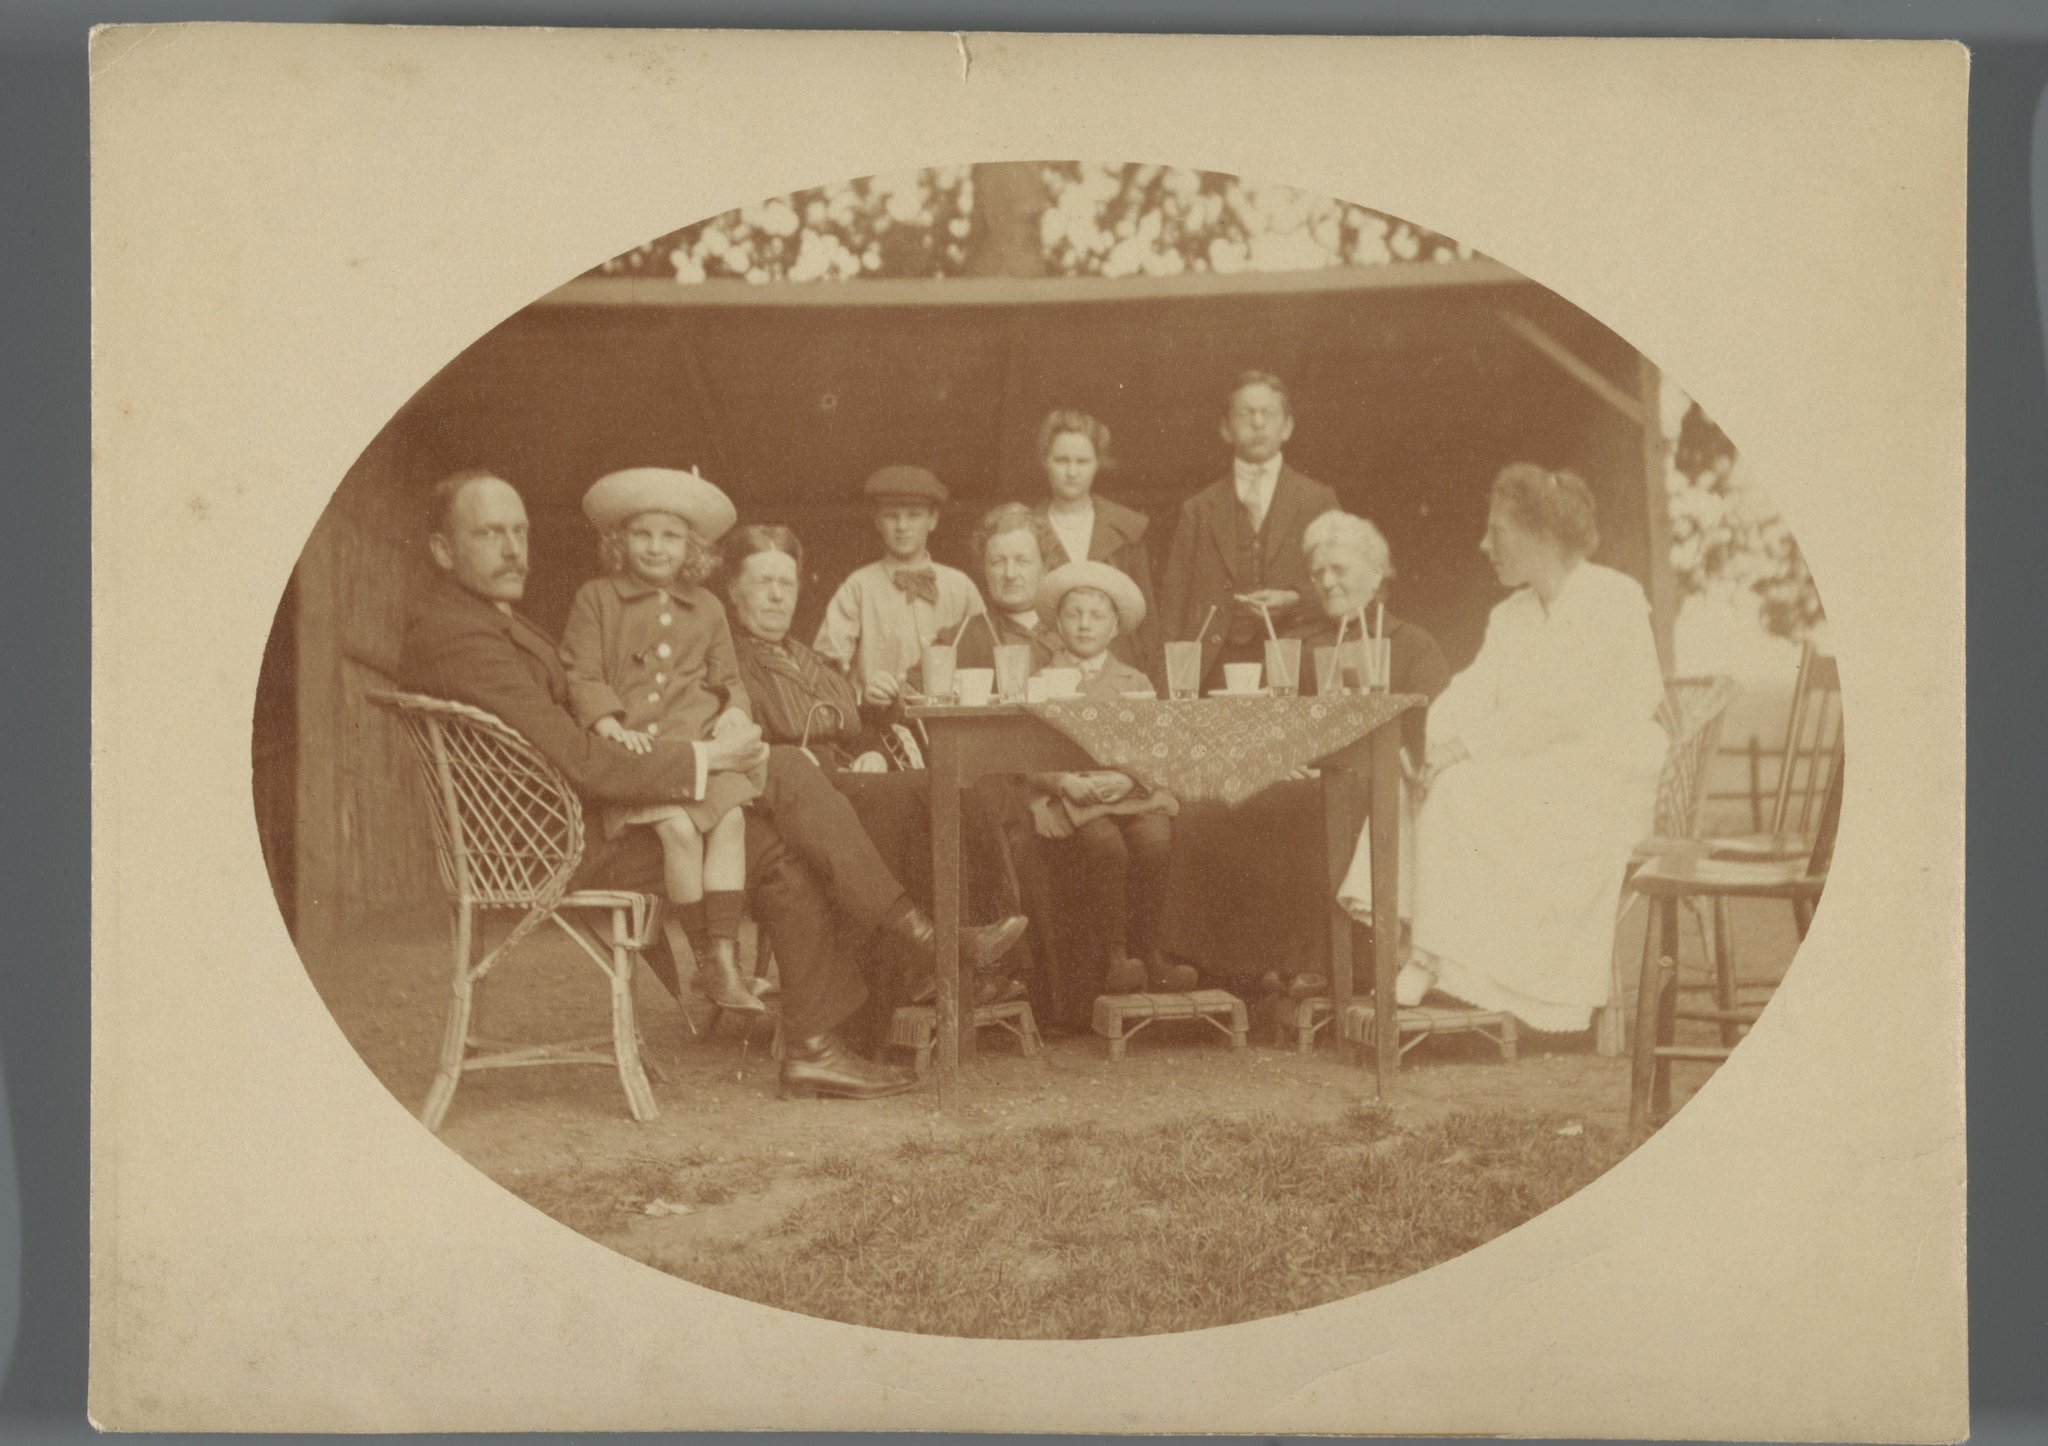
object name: photograph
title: Portret van de familie Fontein rond een tafel in een tuin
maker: Anonymous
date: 1919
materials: photographic support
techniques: gelatin silver print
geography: netherlands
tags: anonymous historical persons portrayed in a group, in a group-portrait